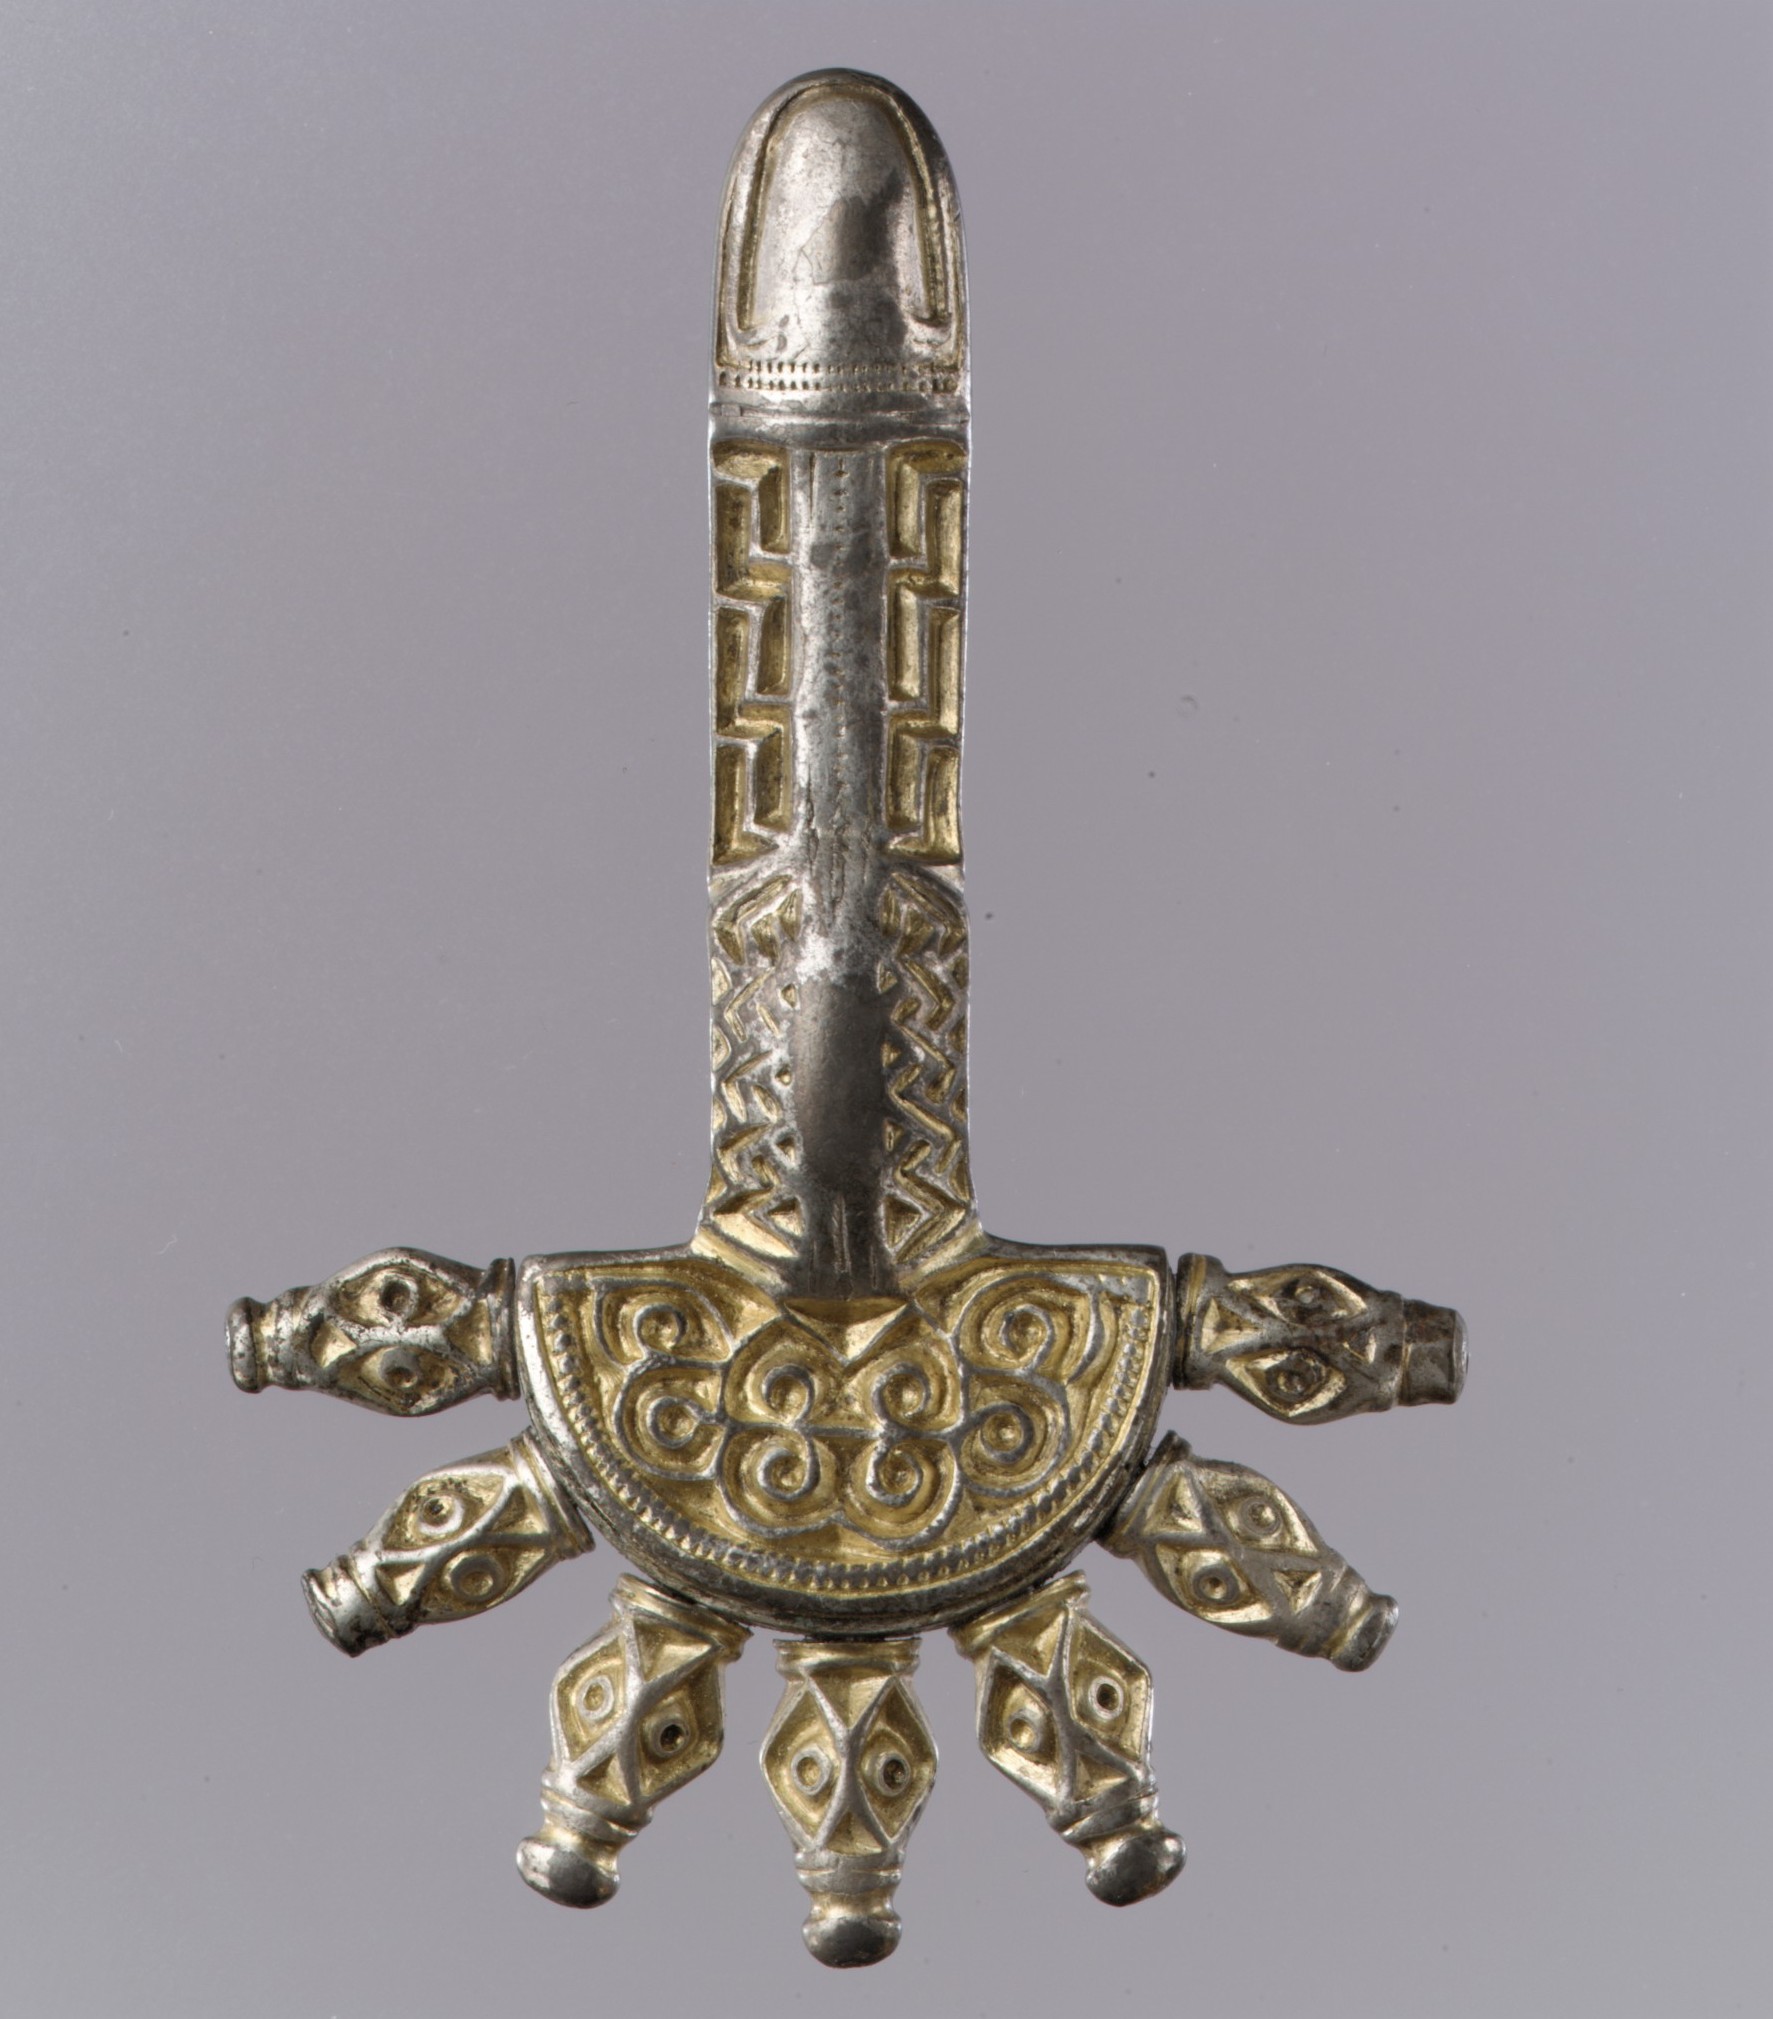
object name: brooch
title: Bow Brooch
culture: alemannic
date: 467-533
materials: silver gilt